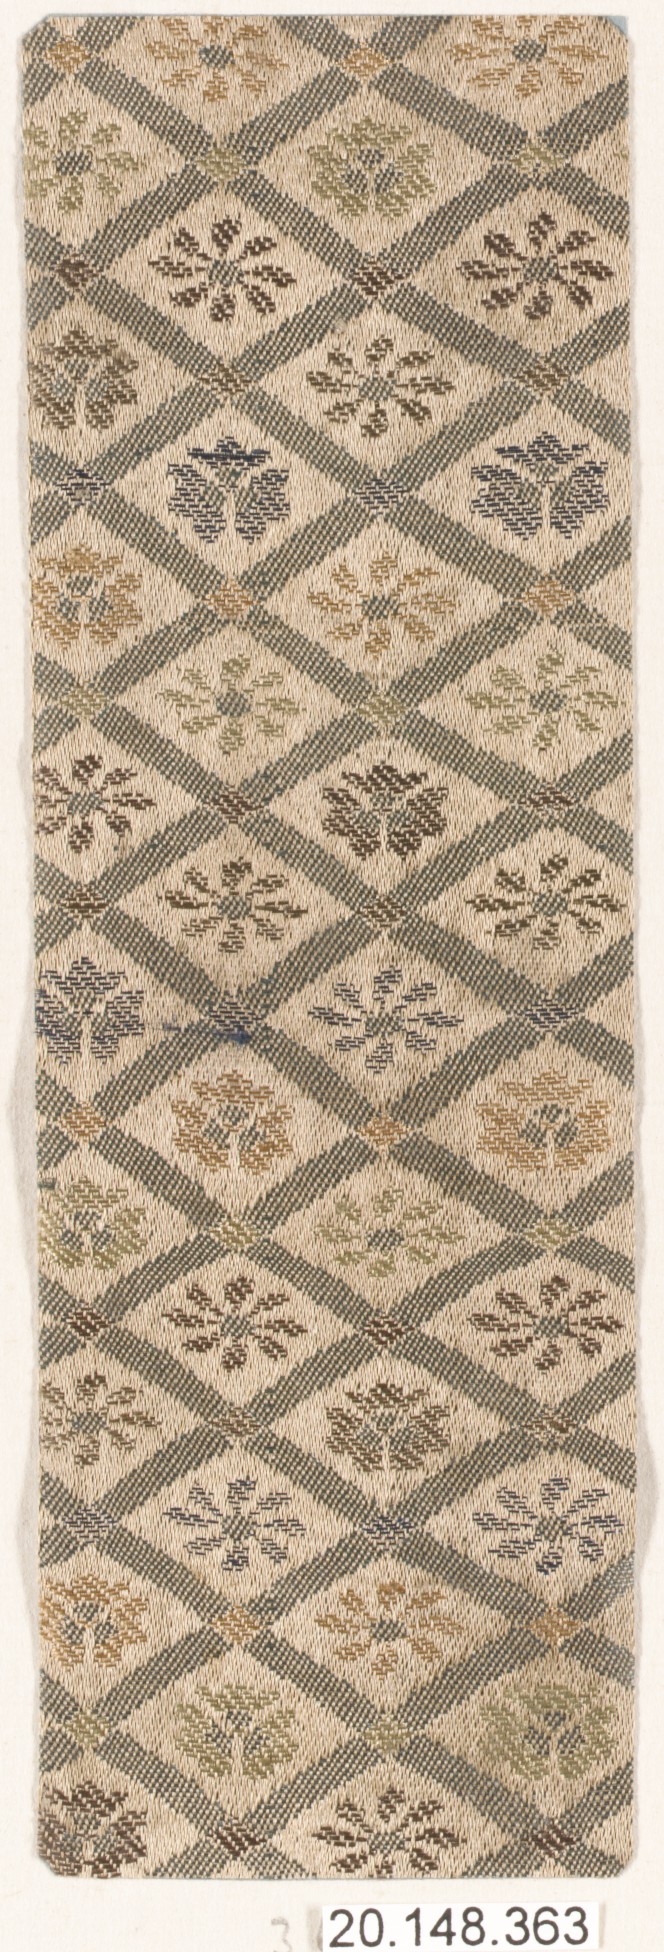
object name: piece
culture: japanese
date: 1701-1800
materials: silk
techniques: compound weave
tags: flowers